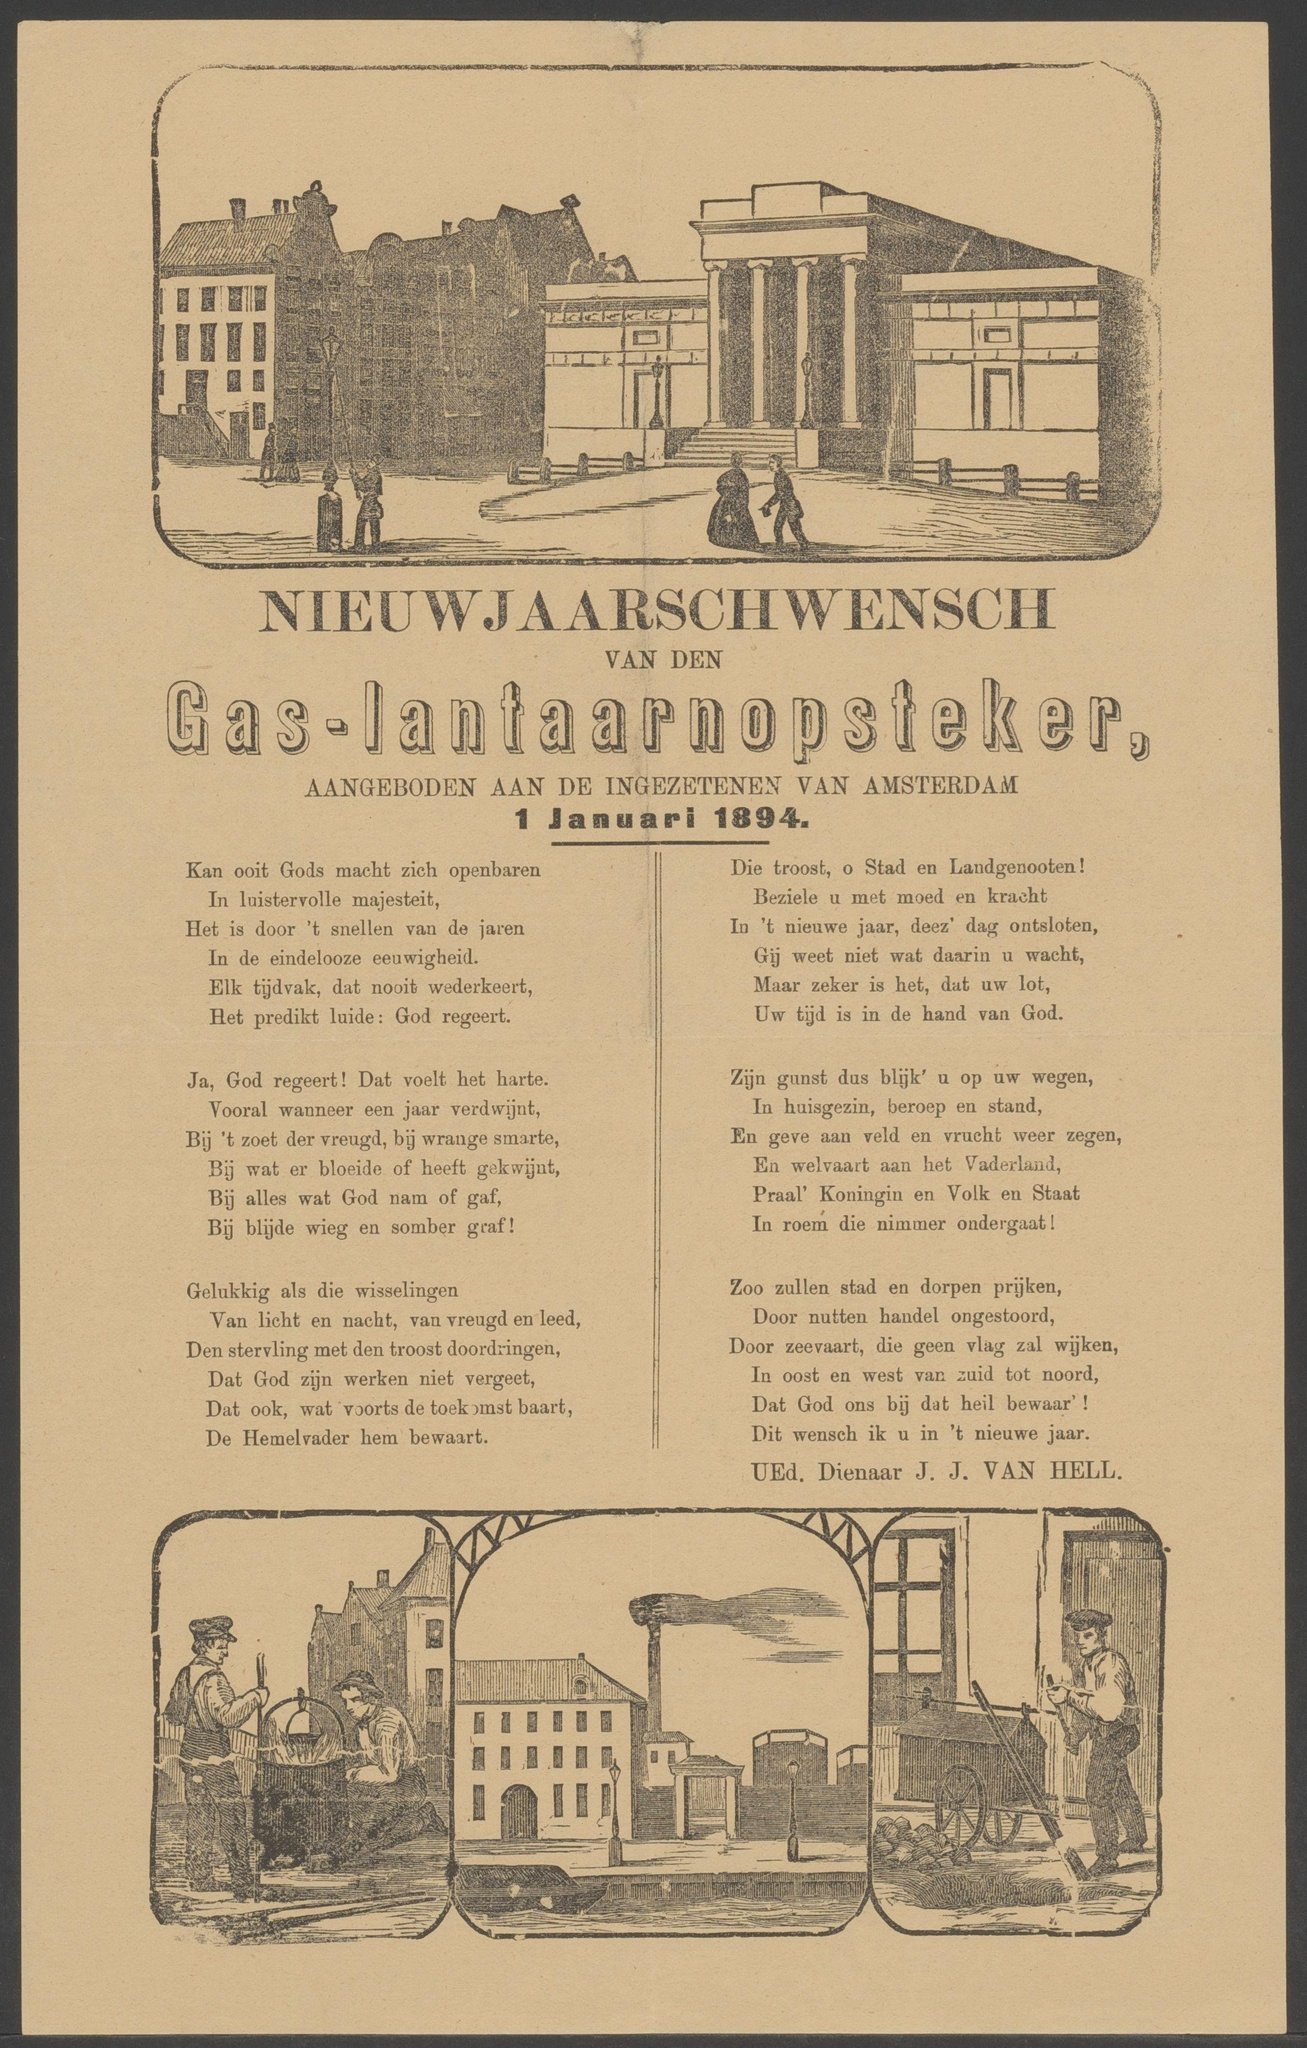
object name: print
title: Nieuwjaarschwensch van den Gas-lantaarnopsteker, aangeboden aan de ingezetenen van Amsterdam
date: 1894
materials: paper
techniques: letterpress printing, engraving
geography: amsterdam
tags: gas-lamp, gas supply, digging (industrial process), street lighting, amsterdam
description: Nieuwjaarswens van de Amsterdamse gaslantaarnopstekers voor het jaar 1894. Centraal een vers in twee kolommen. Bovenaan de Dam met de beurs van Zocher te Amsterdam. Onderaan de Hollandsche Gasfabriek en twee gasfitters aan het werk. Van de gaslantaarnopsteker: J.J. van Hell. Onderwerpsrubrieken binnen de Atlas Zeden en Gewoonten: Zeden en gewoonten in engeren zin, Volksleven, Volksbladen, Nieuwjaars- en Kerstwenschen, Amsterdam.